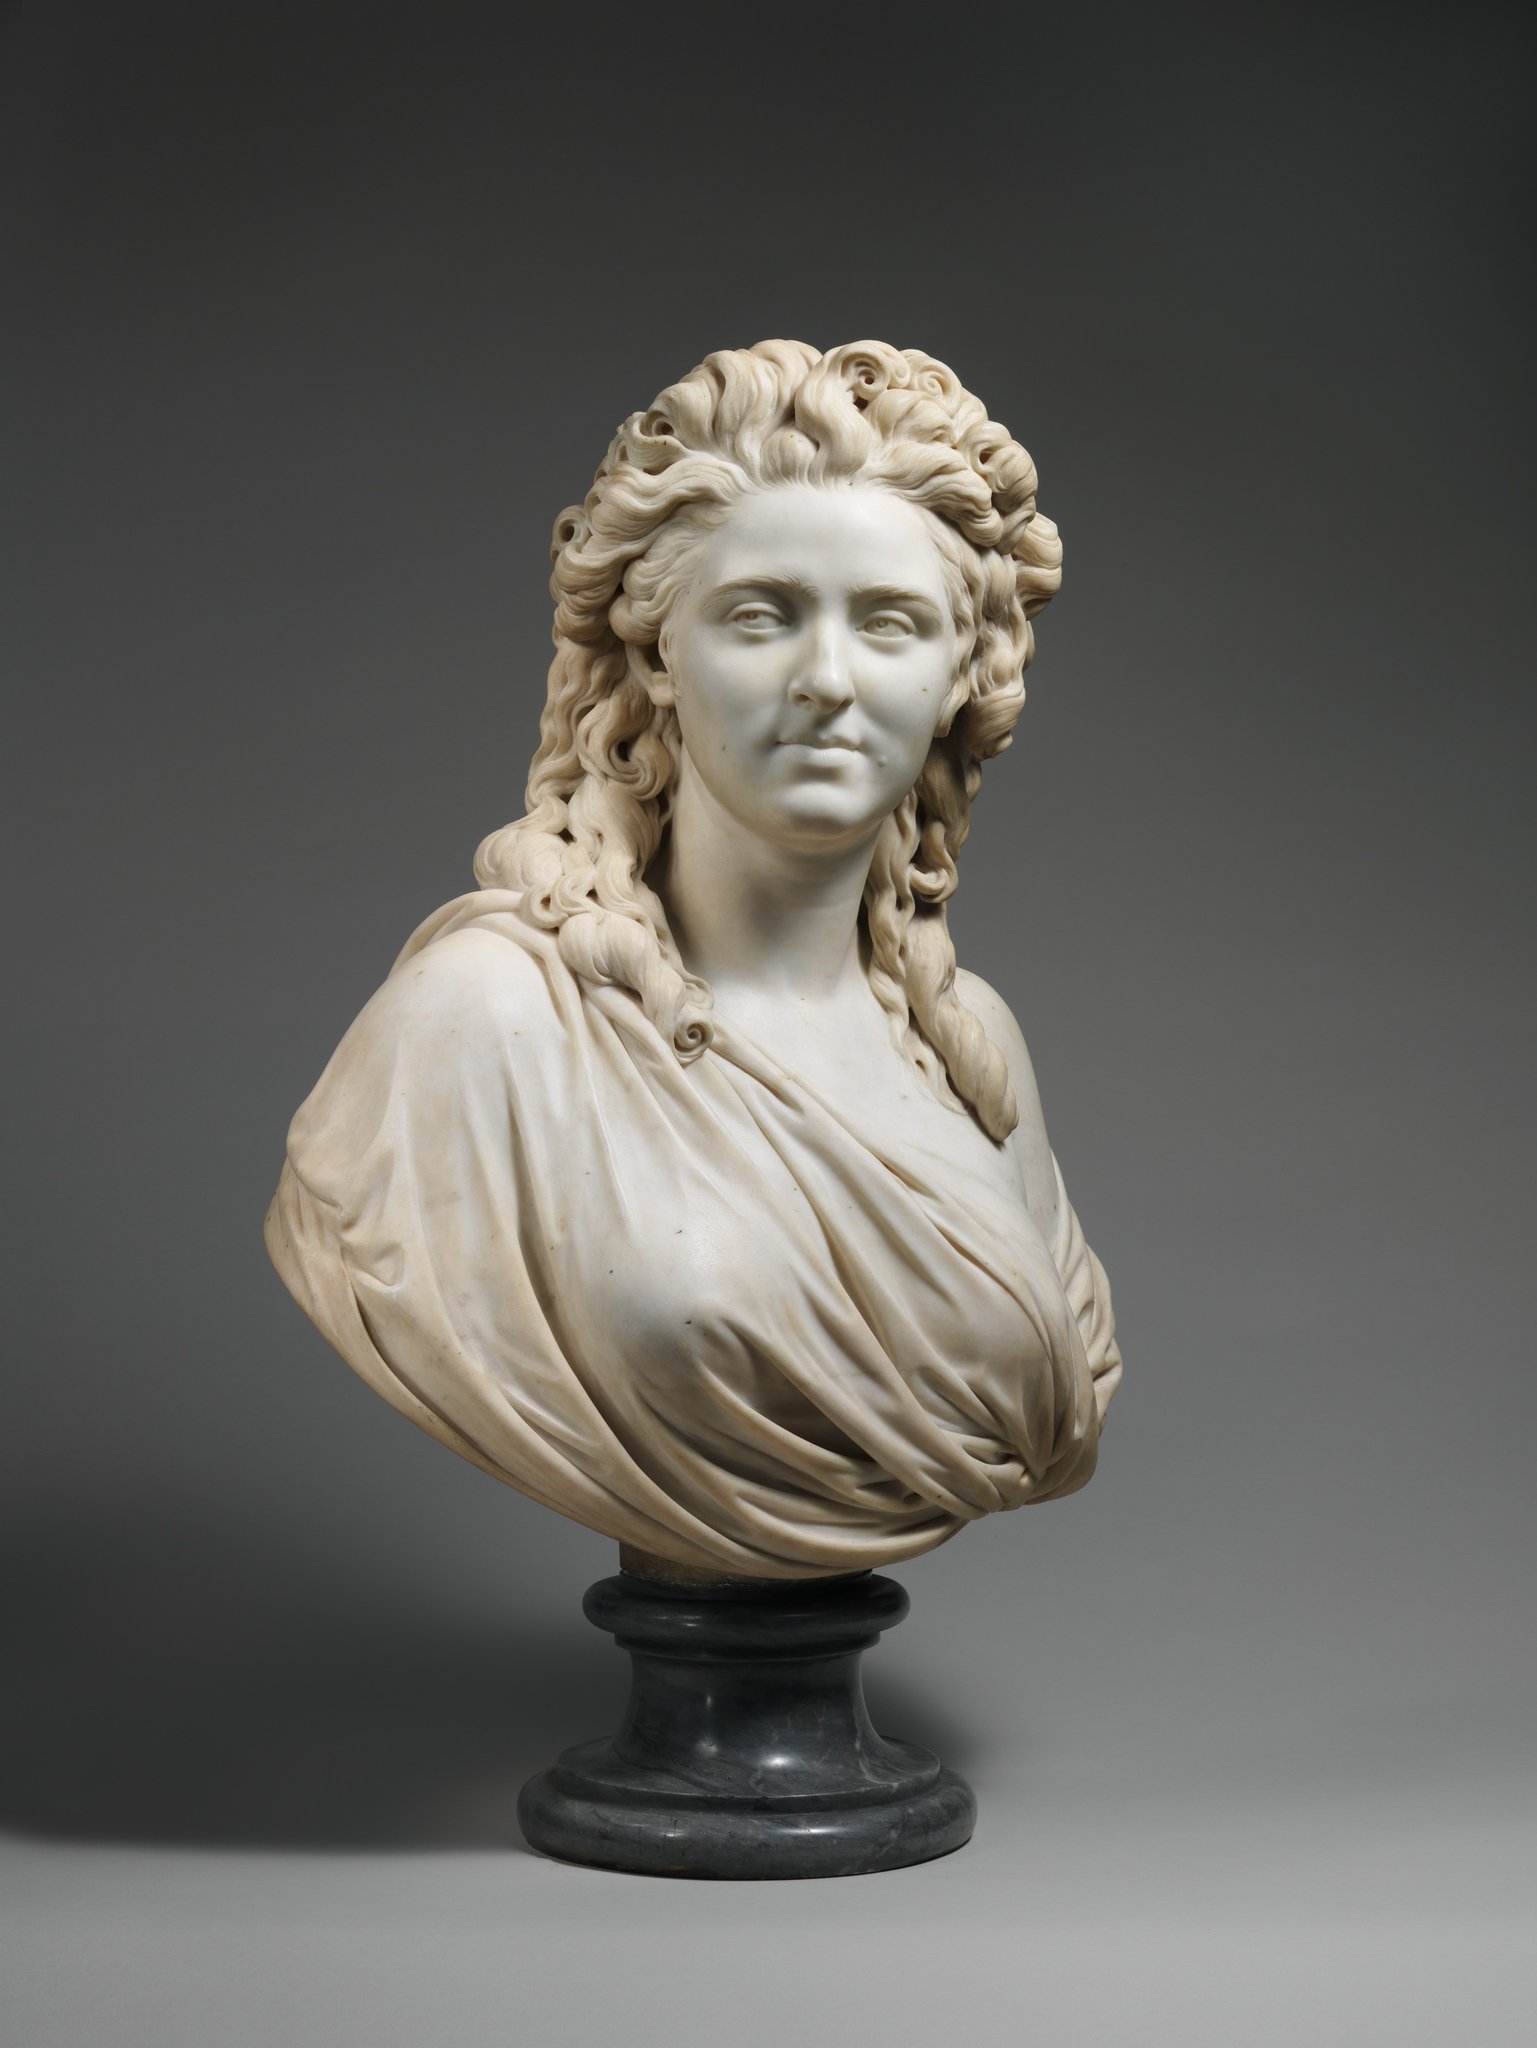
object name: bust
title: Madame de Wailly, née Adélaïde-Flore Belleville (1765–1838)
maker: augustin pajou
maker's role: artist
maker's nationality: french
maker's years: 1730-1809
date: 1789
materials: marble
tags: portraits,women